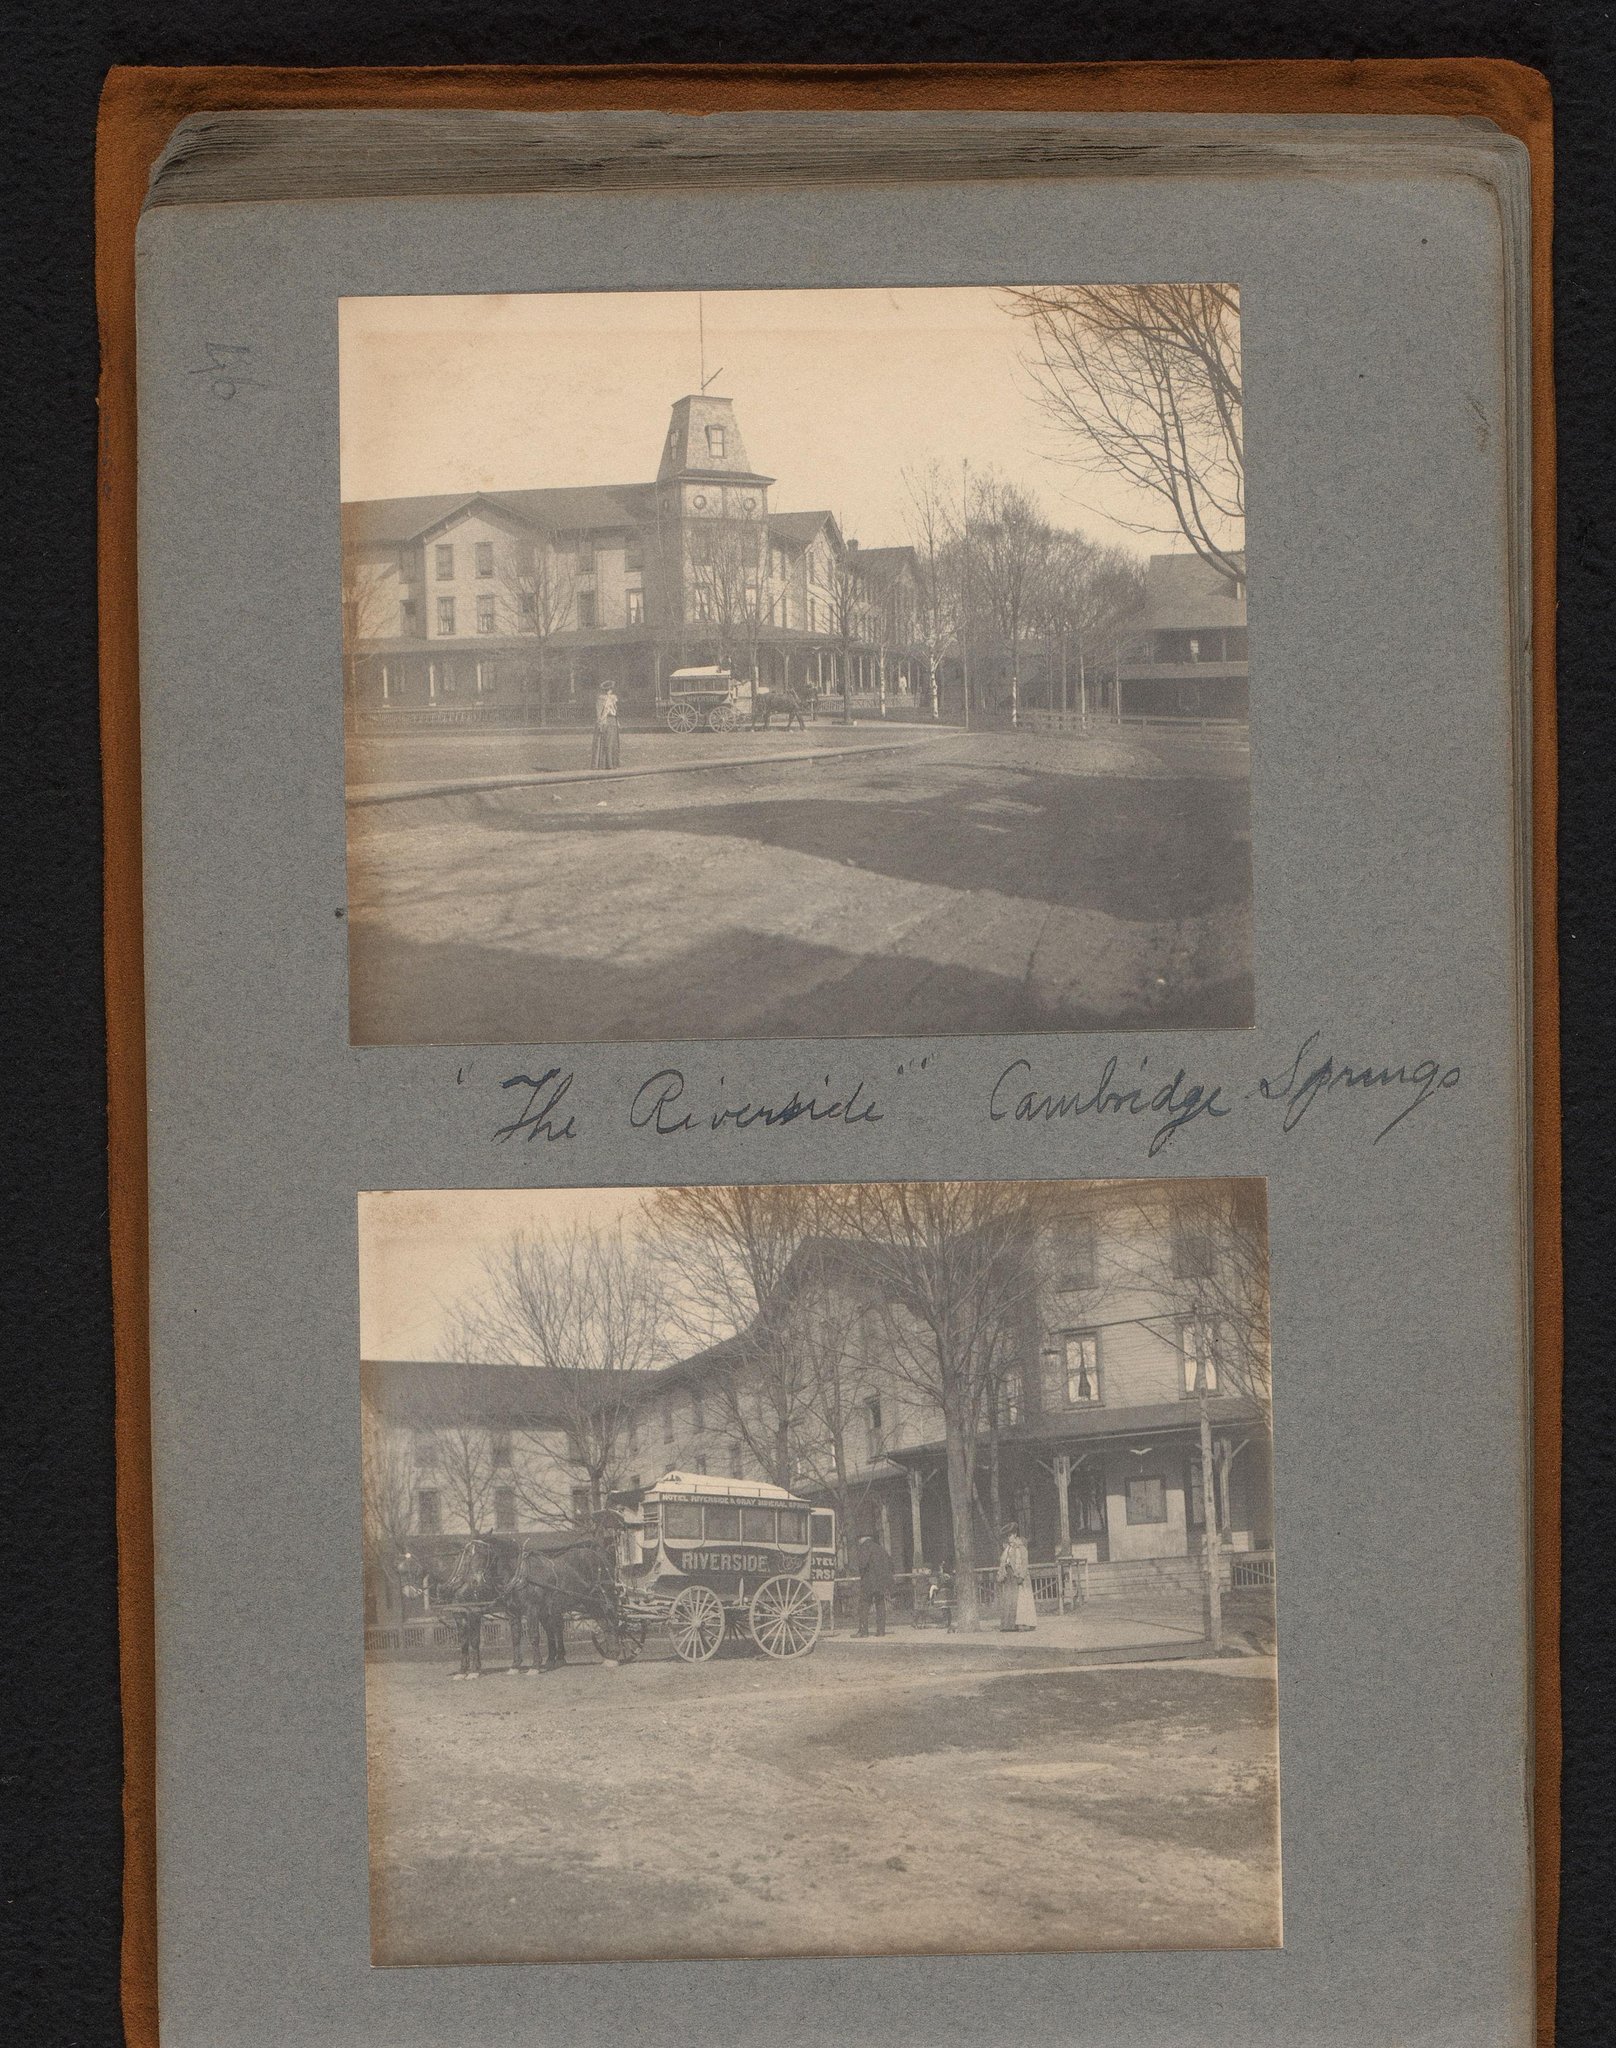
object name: album leaf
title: The Riverside Cambridge Springs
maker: jan van der mey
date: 1902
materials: paper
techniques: gelatin silver print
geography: pennsylvania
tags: four-wheeled, animal-drawn vehicle, e.g.: cab, carriage, coach, hotel, hostelry, inn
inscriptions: inscription: ‘"The Riverside" Cambridge Springs’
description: Deze foto's maken deel uit van een album.